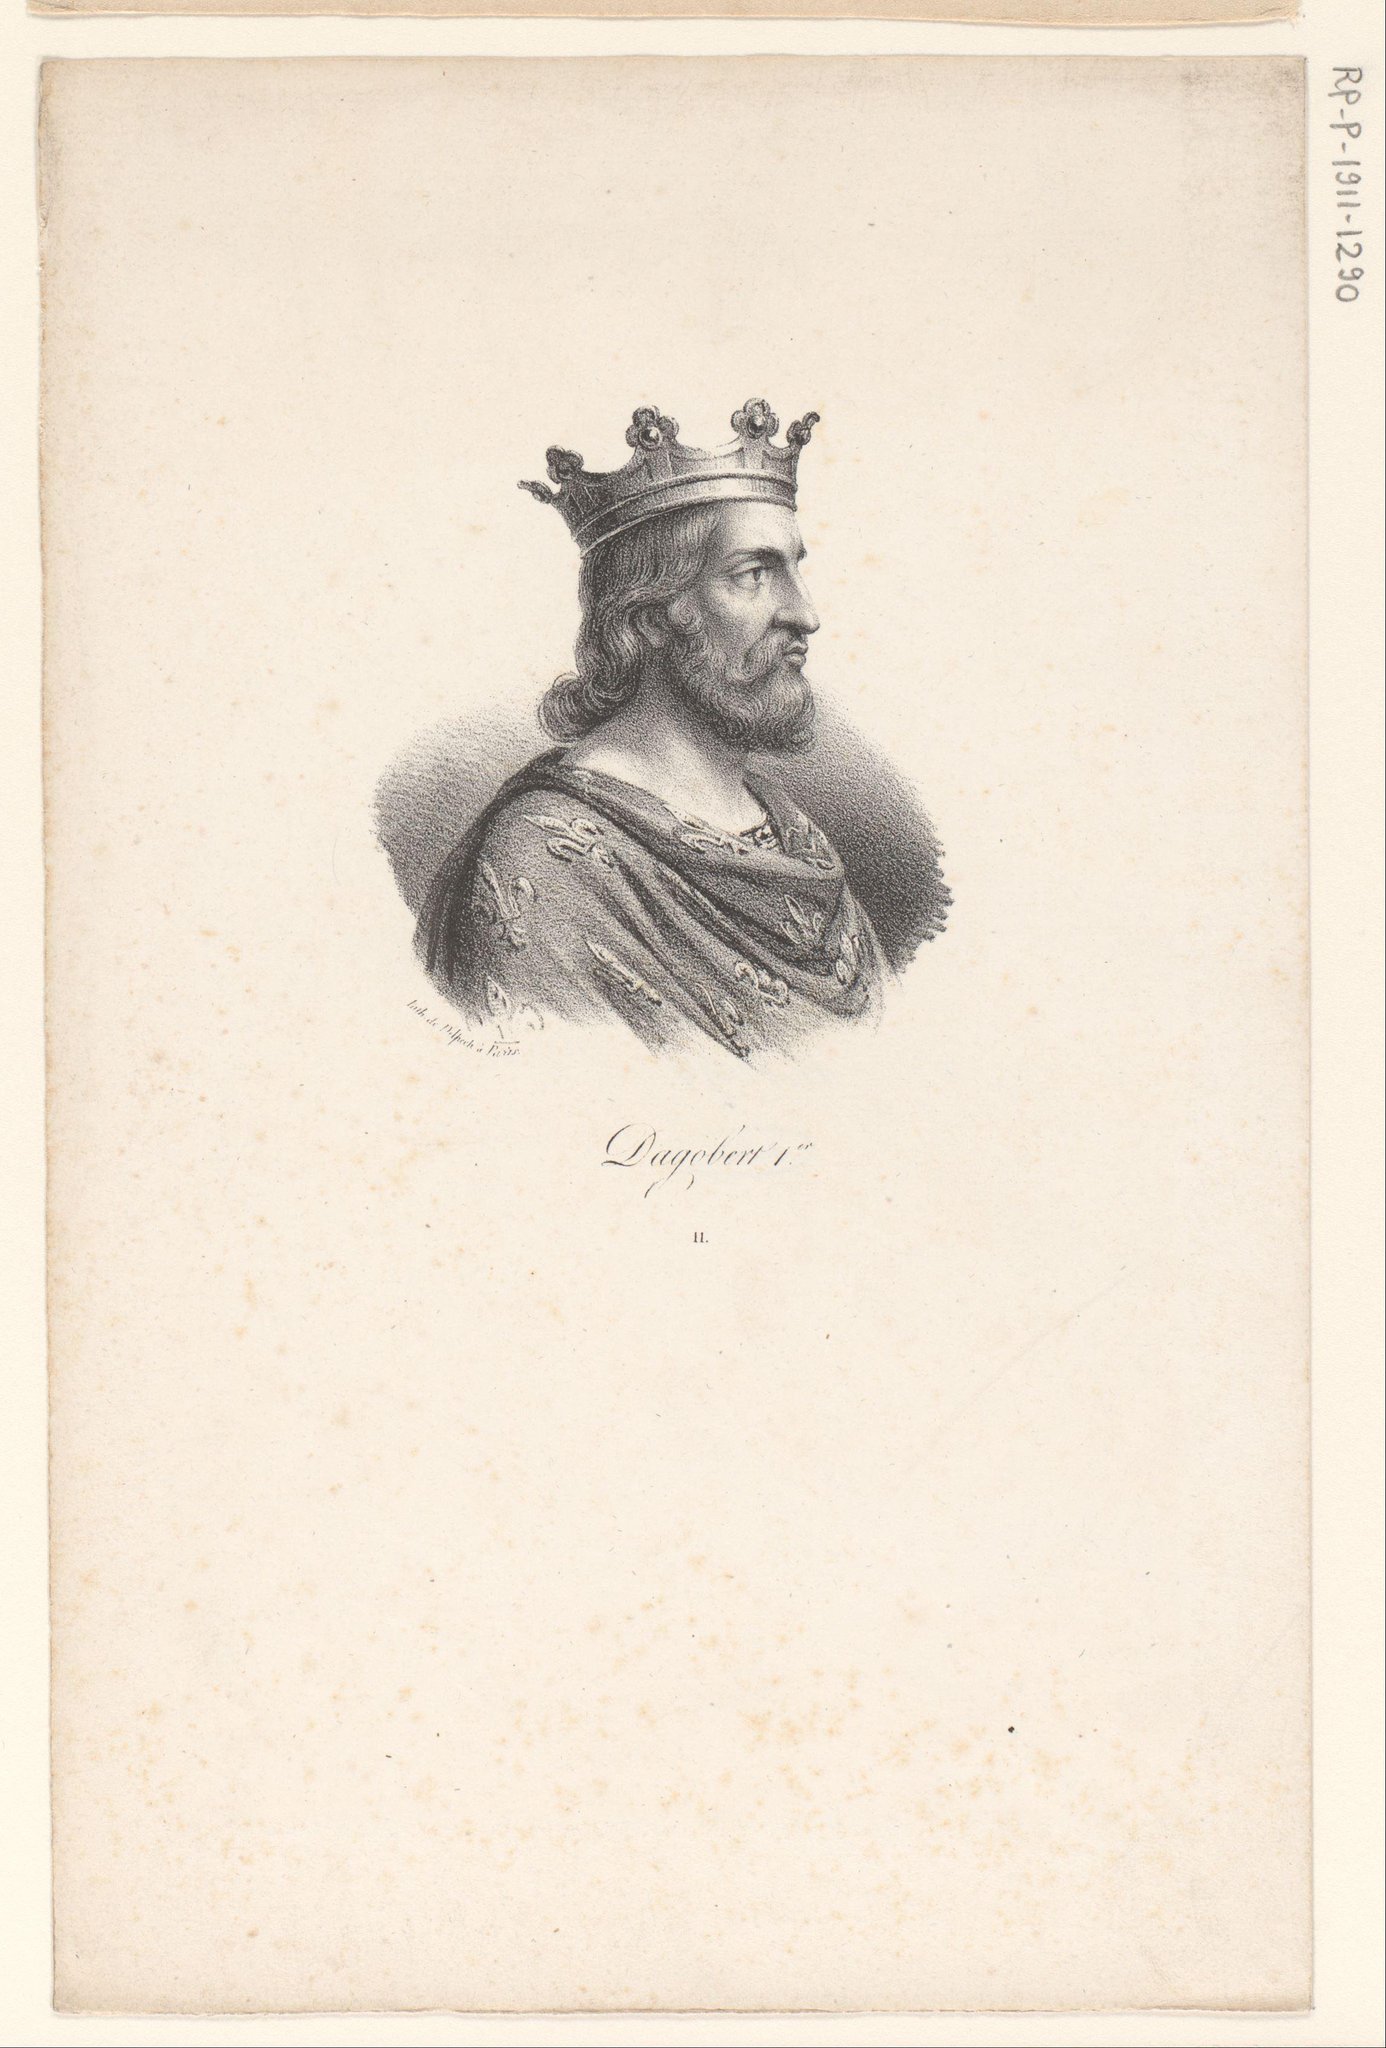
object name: print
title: Portret van koning Dagobert I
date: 1818-1842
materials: paper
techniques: lithograph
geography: paris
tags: historical persons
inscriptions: collector's mark: Lugt 2228a